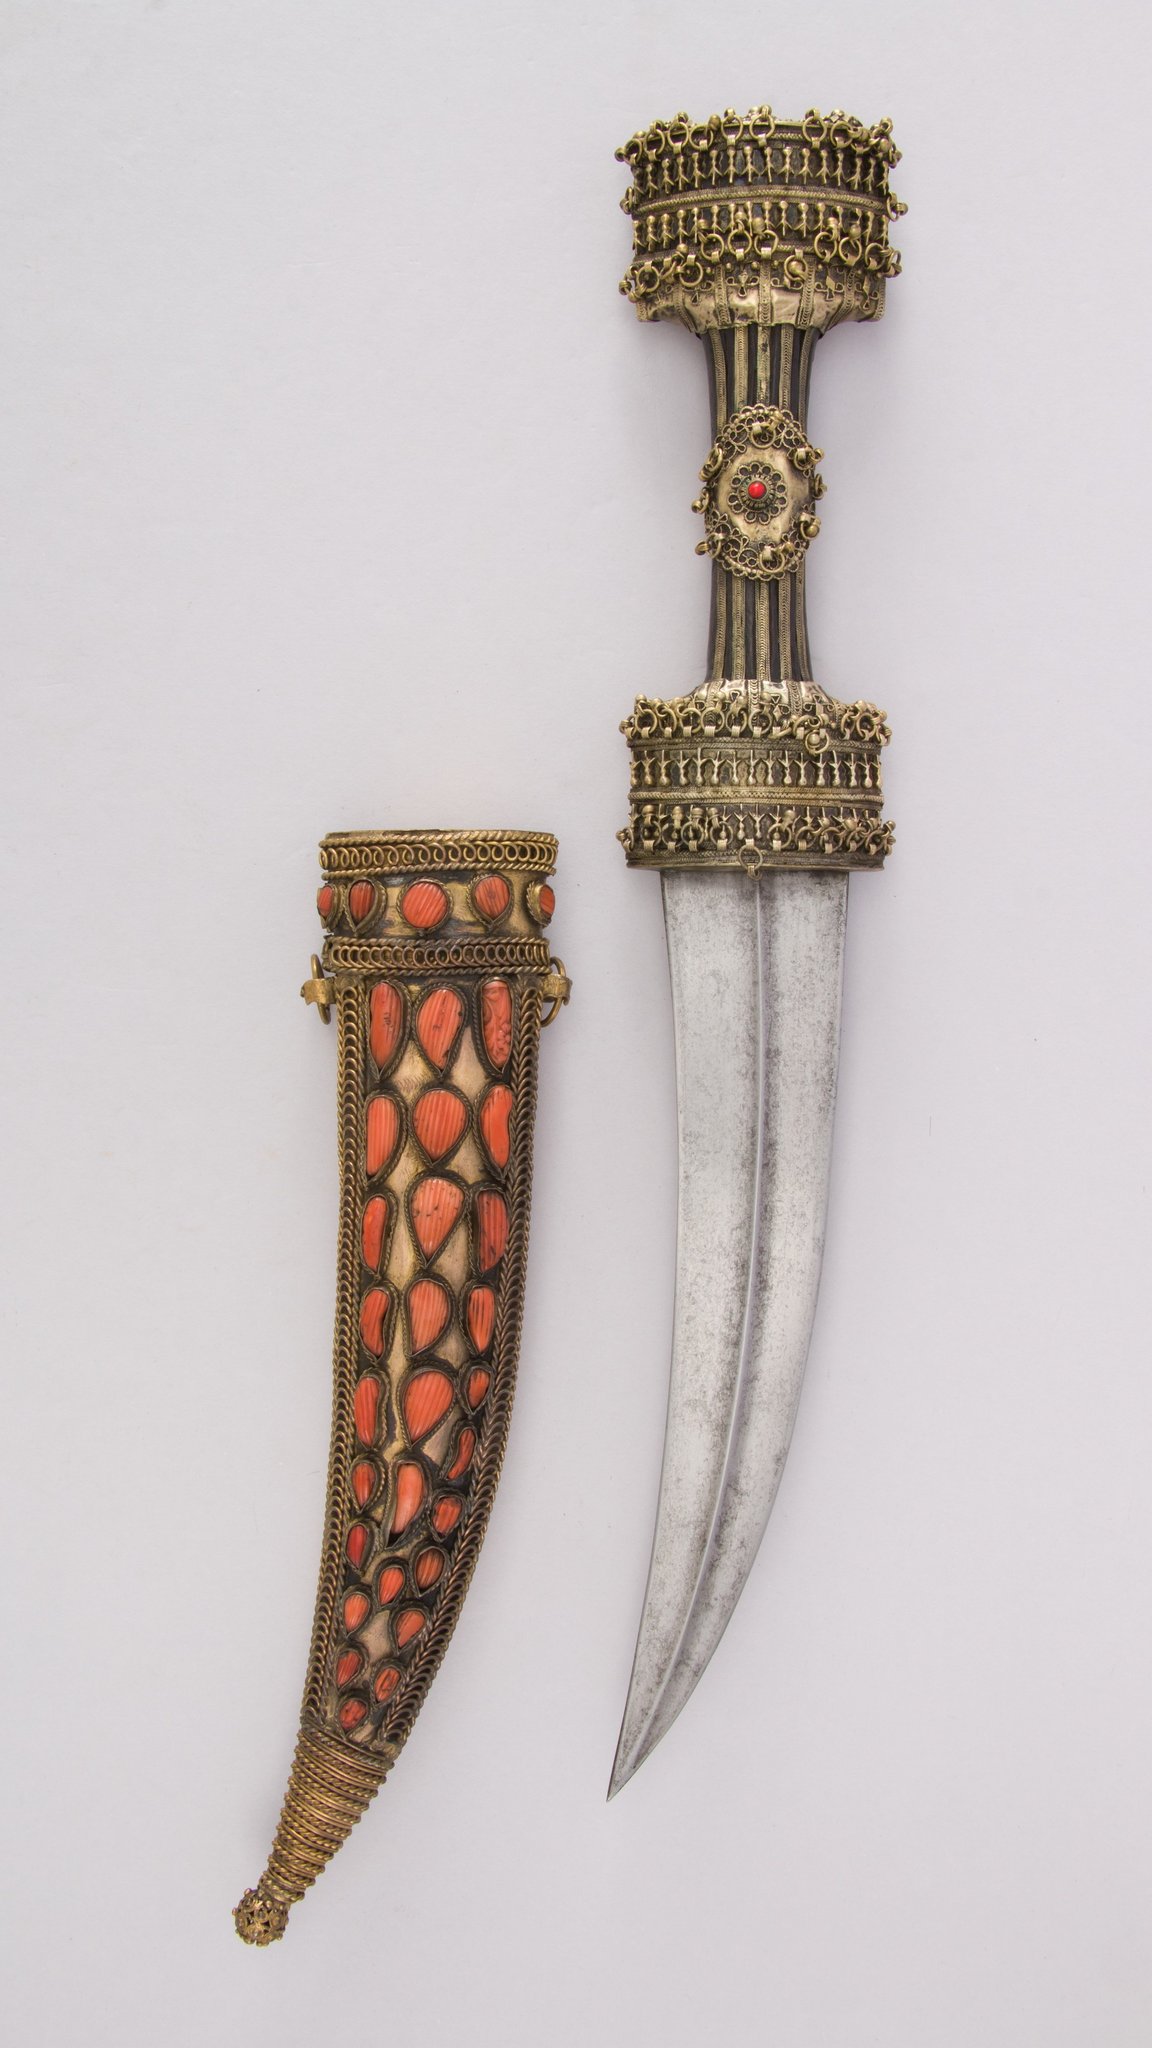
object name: dagger jambiya with sheath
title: Dagger (Jambiya) with Sheath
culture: albanian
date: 1701-1800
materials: brass, copper, coral, gold, steel, wood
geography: albania